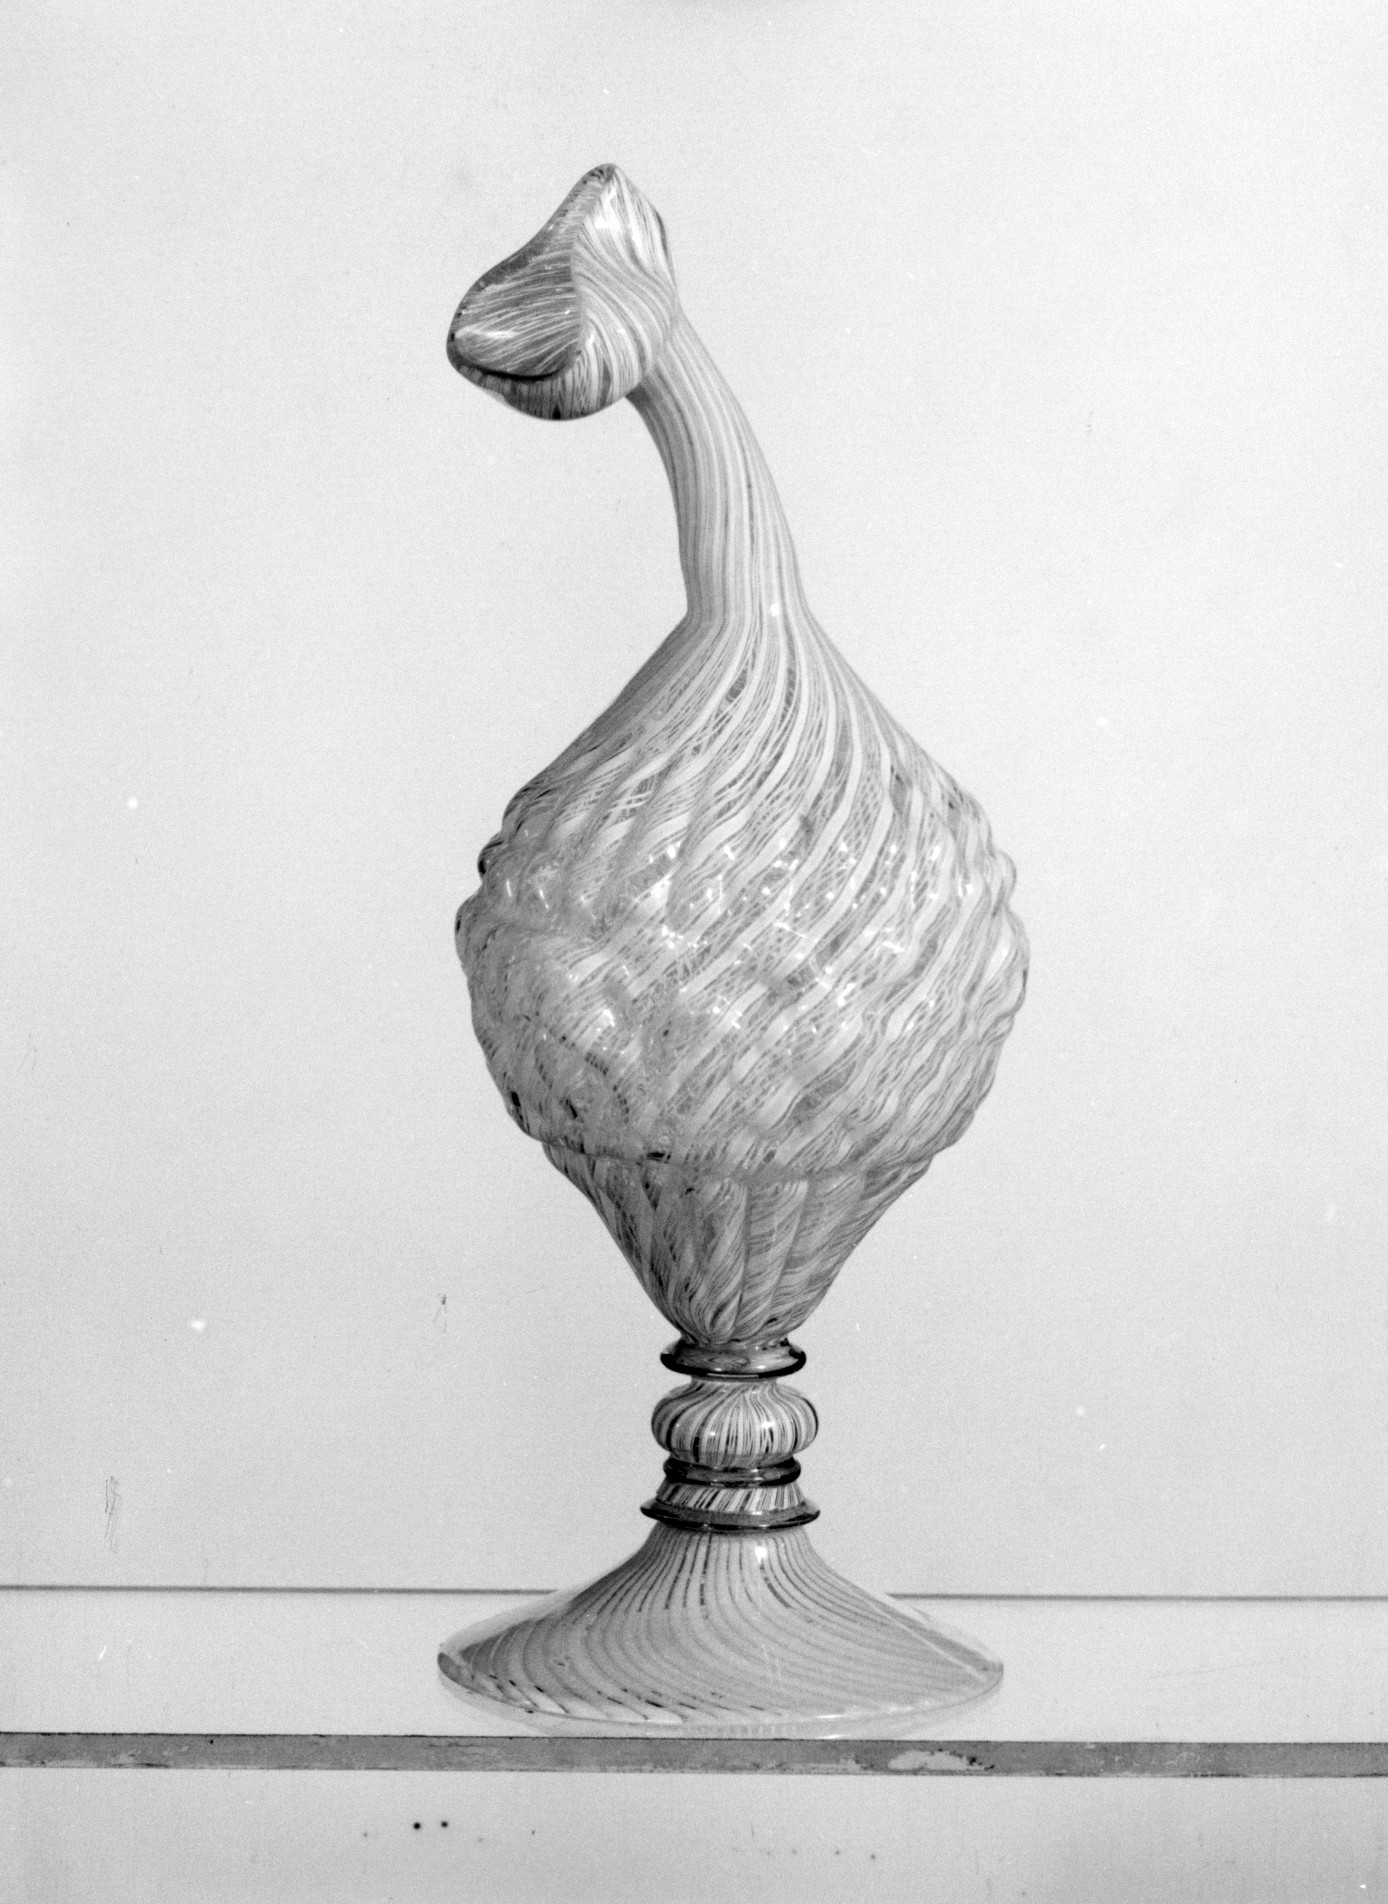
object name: bottle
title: Latticino Bottle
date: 1501-1700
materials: glass